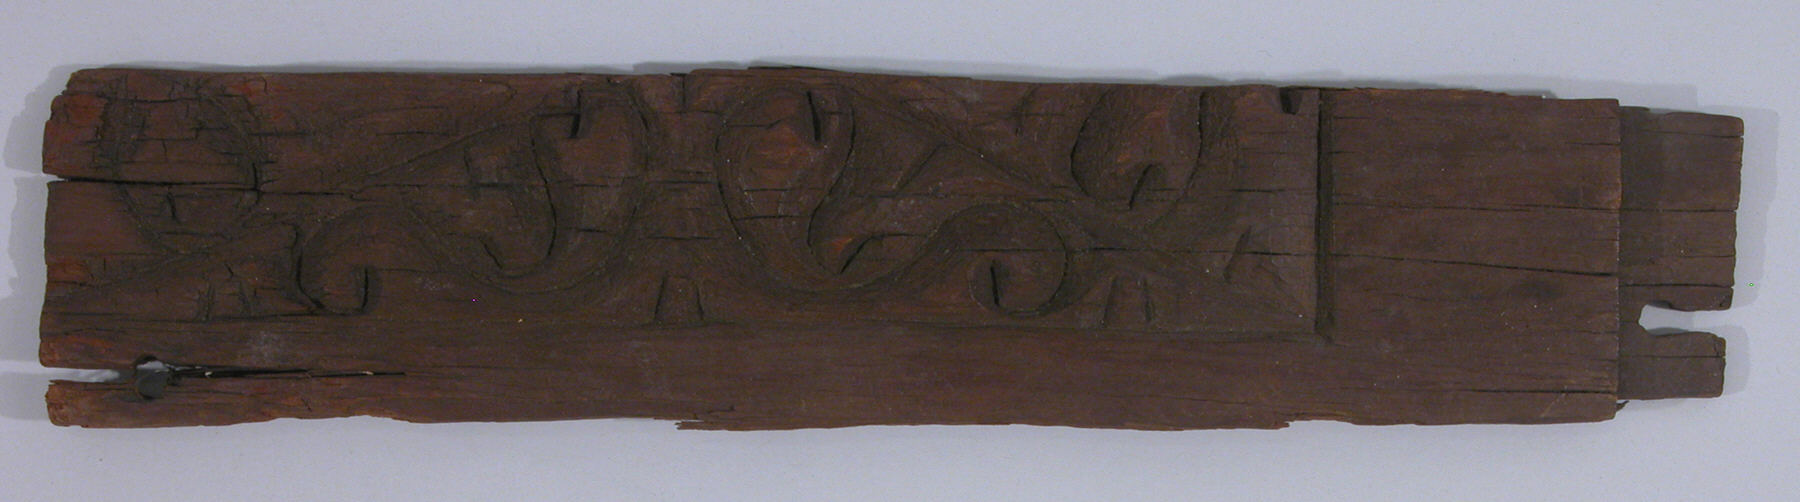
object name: panel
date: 868-905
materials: wood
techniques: carving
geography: egypt